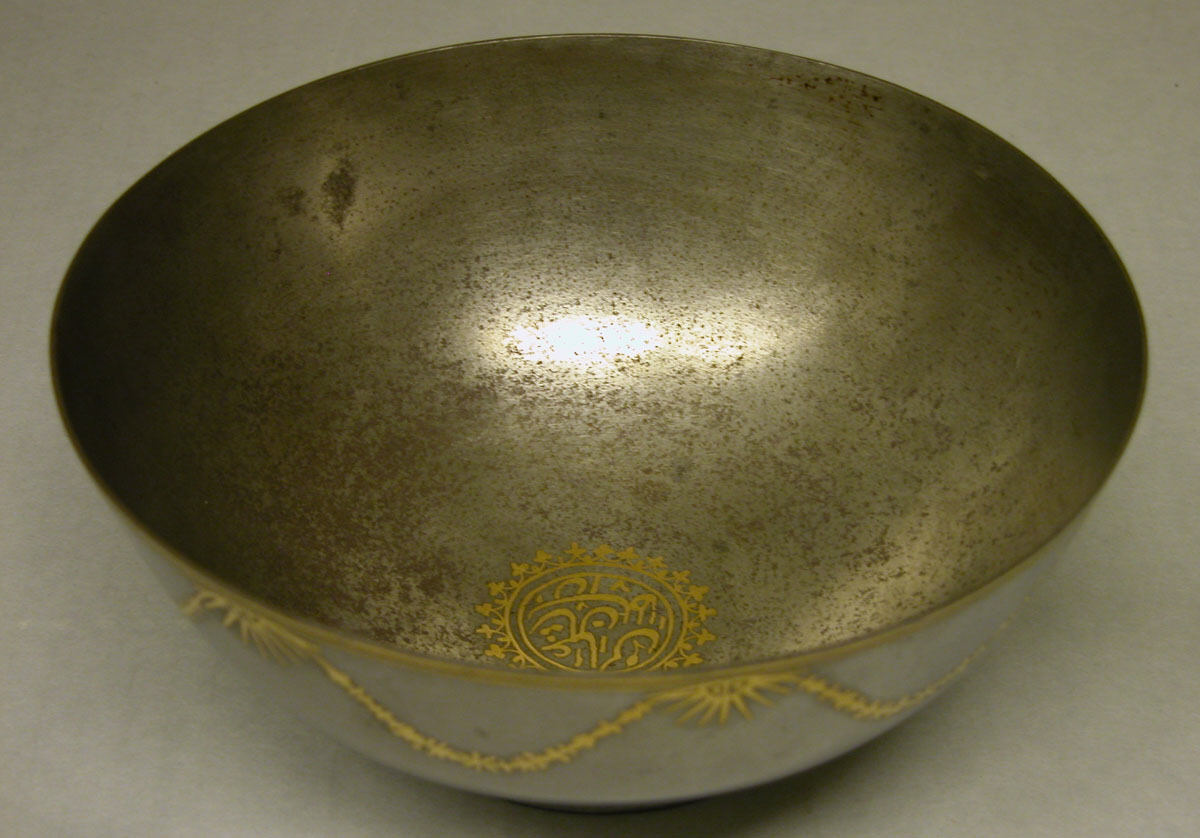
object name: bowl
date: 1701-1900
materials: gold, steel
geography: iran